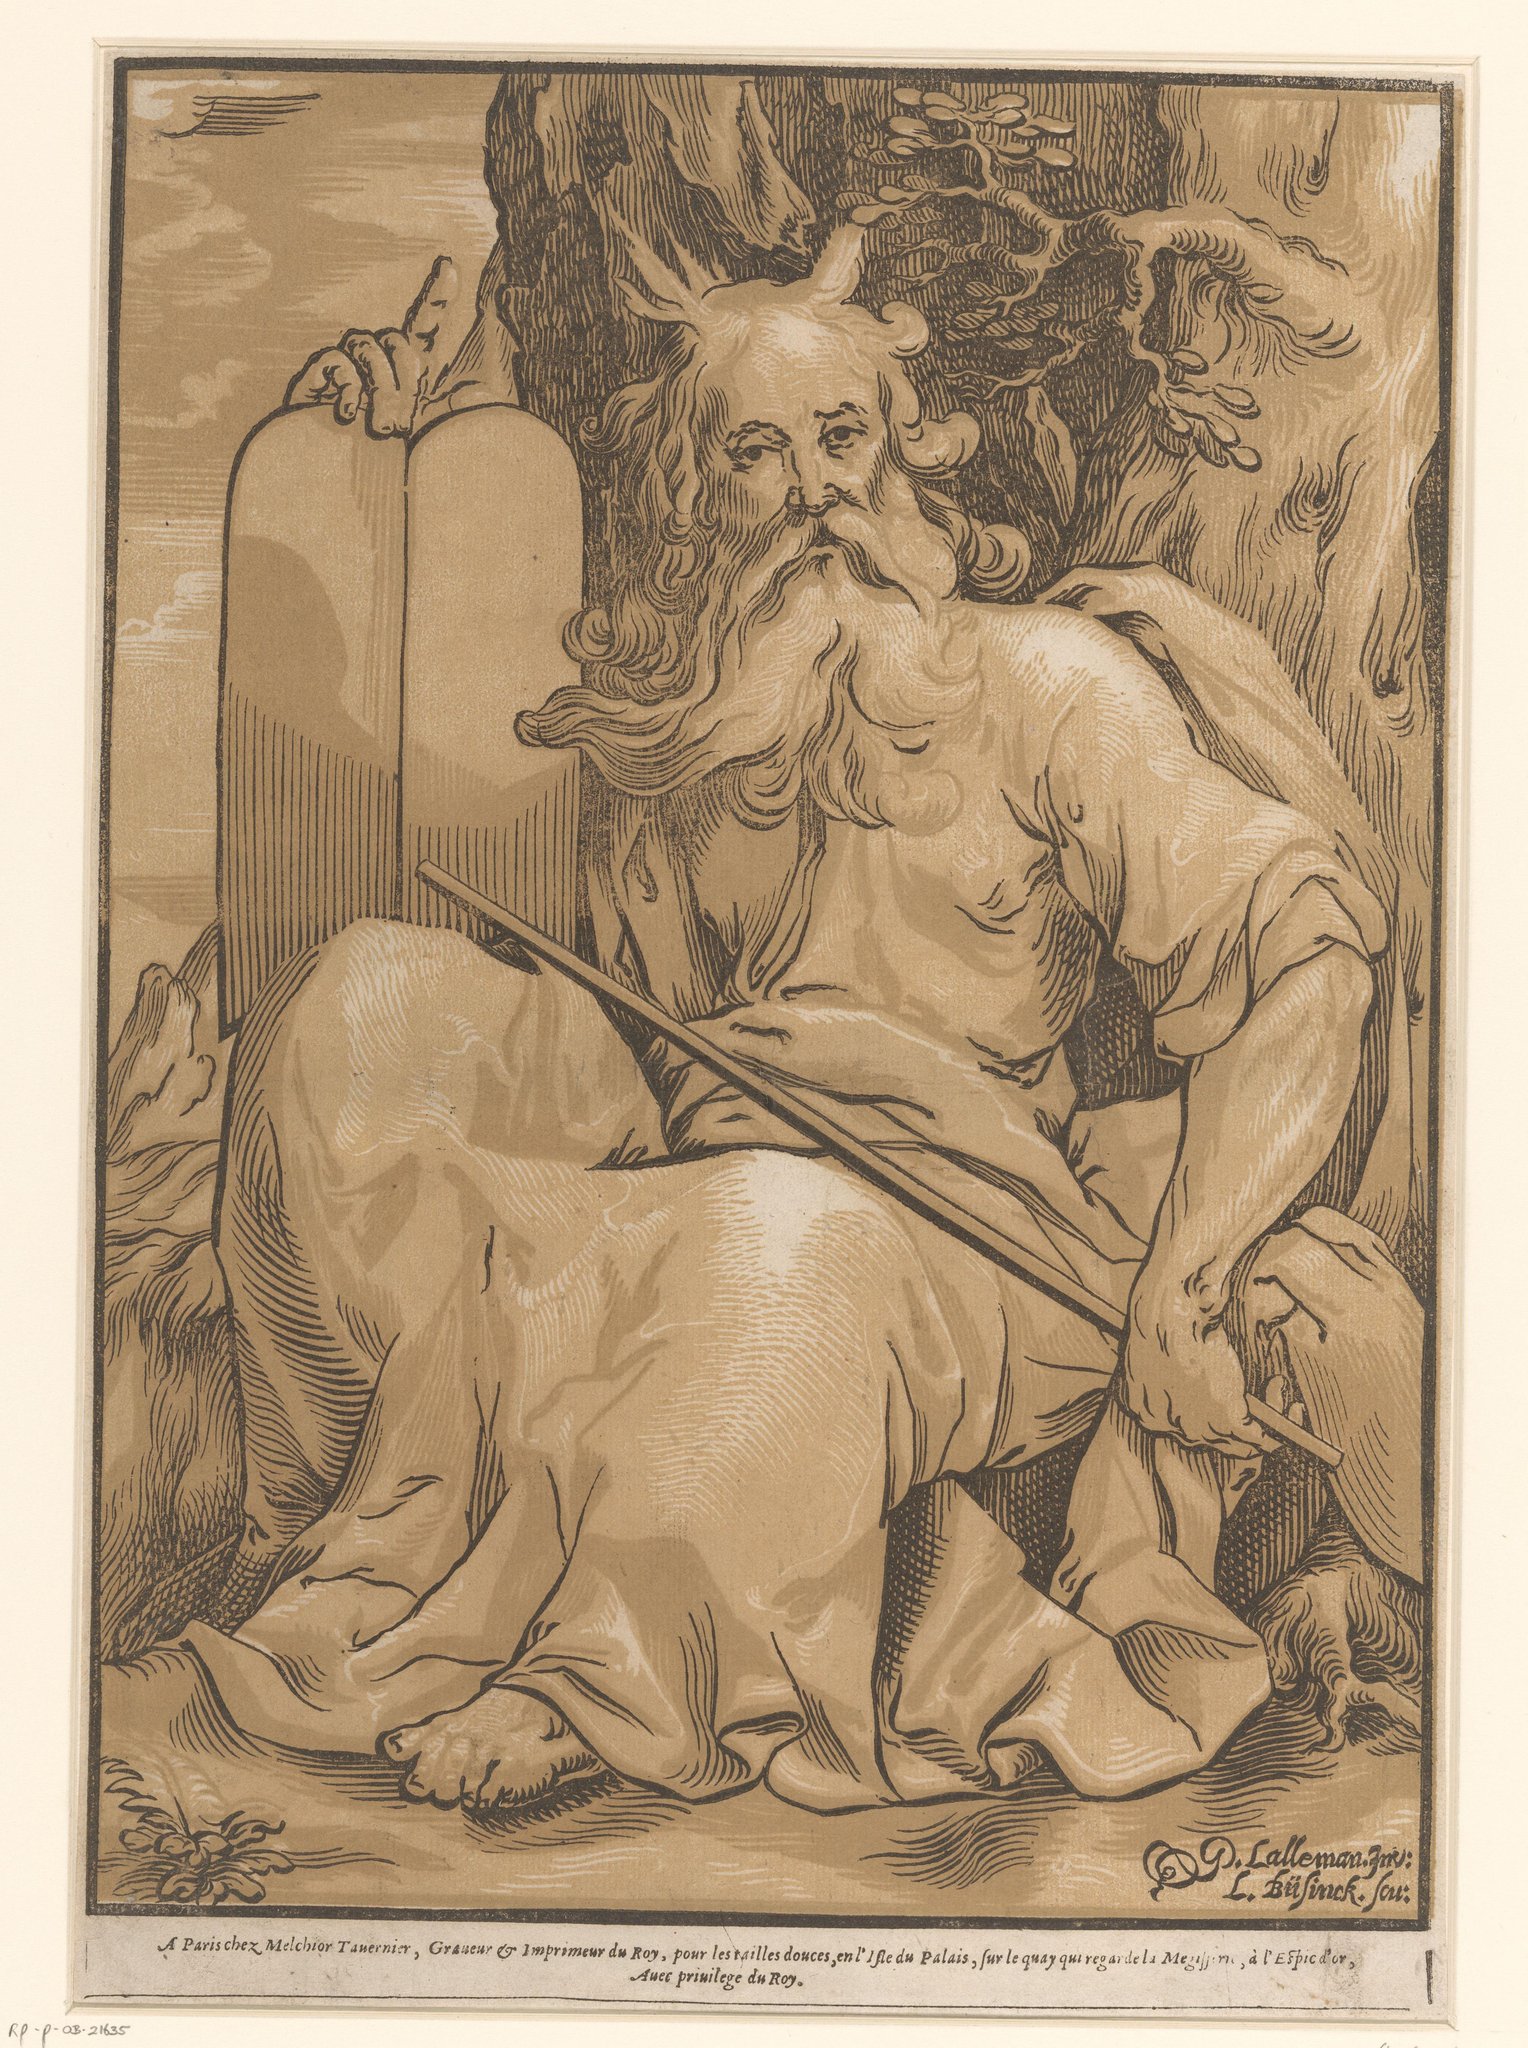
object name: print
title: Mozes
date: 1600-1669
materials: paper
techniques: woodcut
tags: moses (not in biblical context); possible attributes: rays of light or horns on his head, rod, tables of the law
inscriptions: collector's mark: Lugt 240